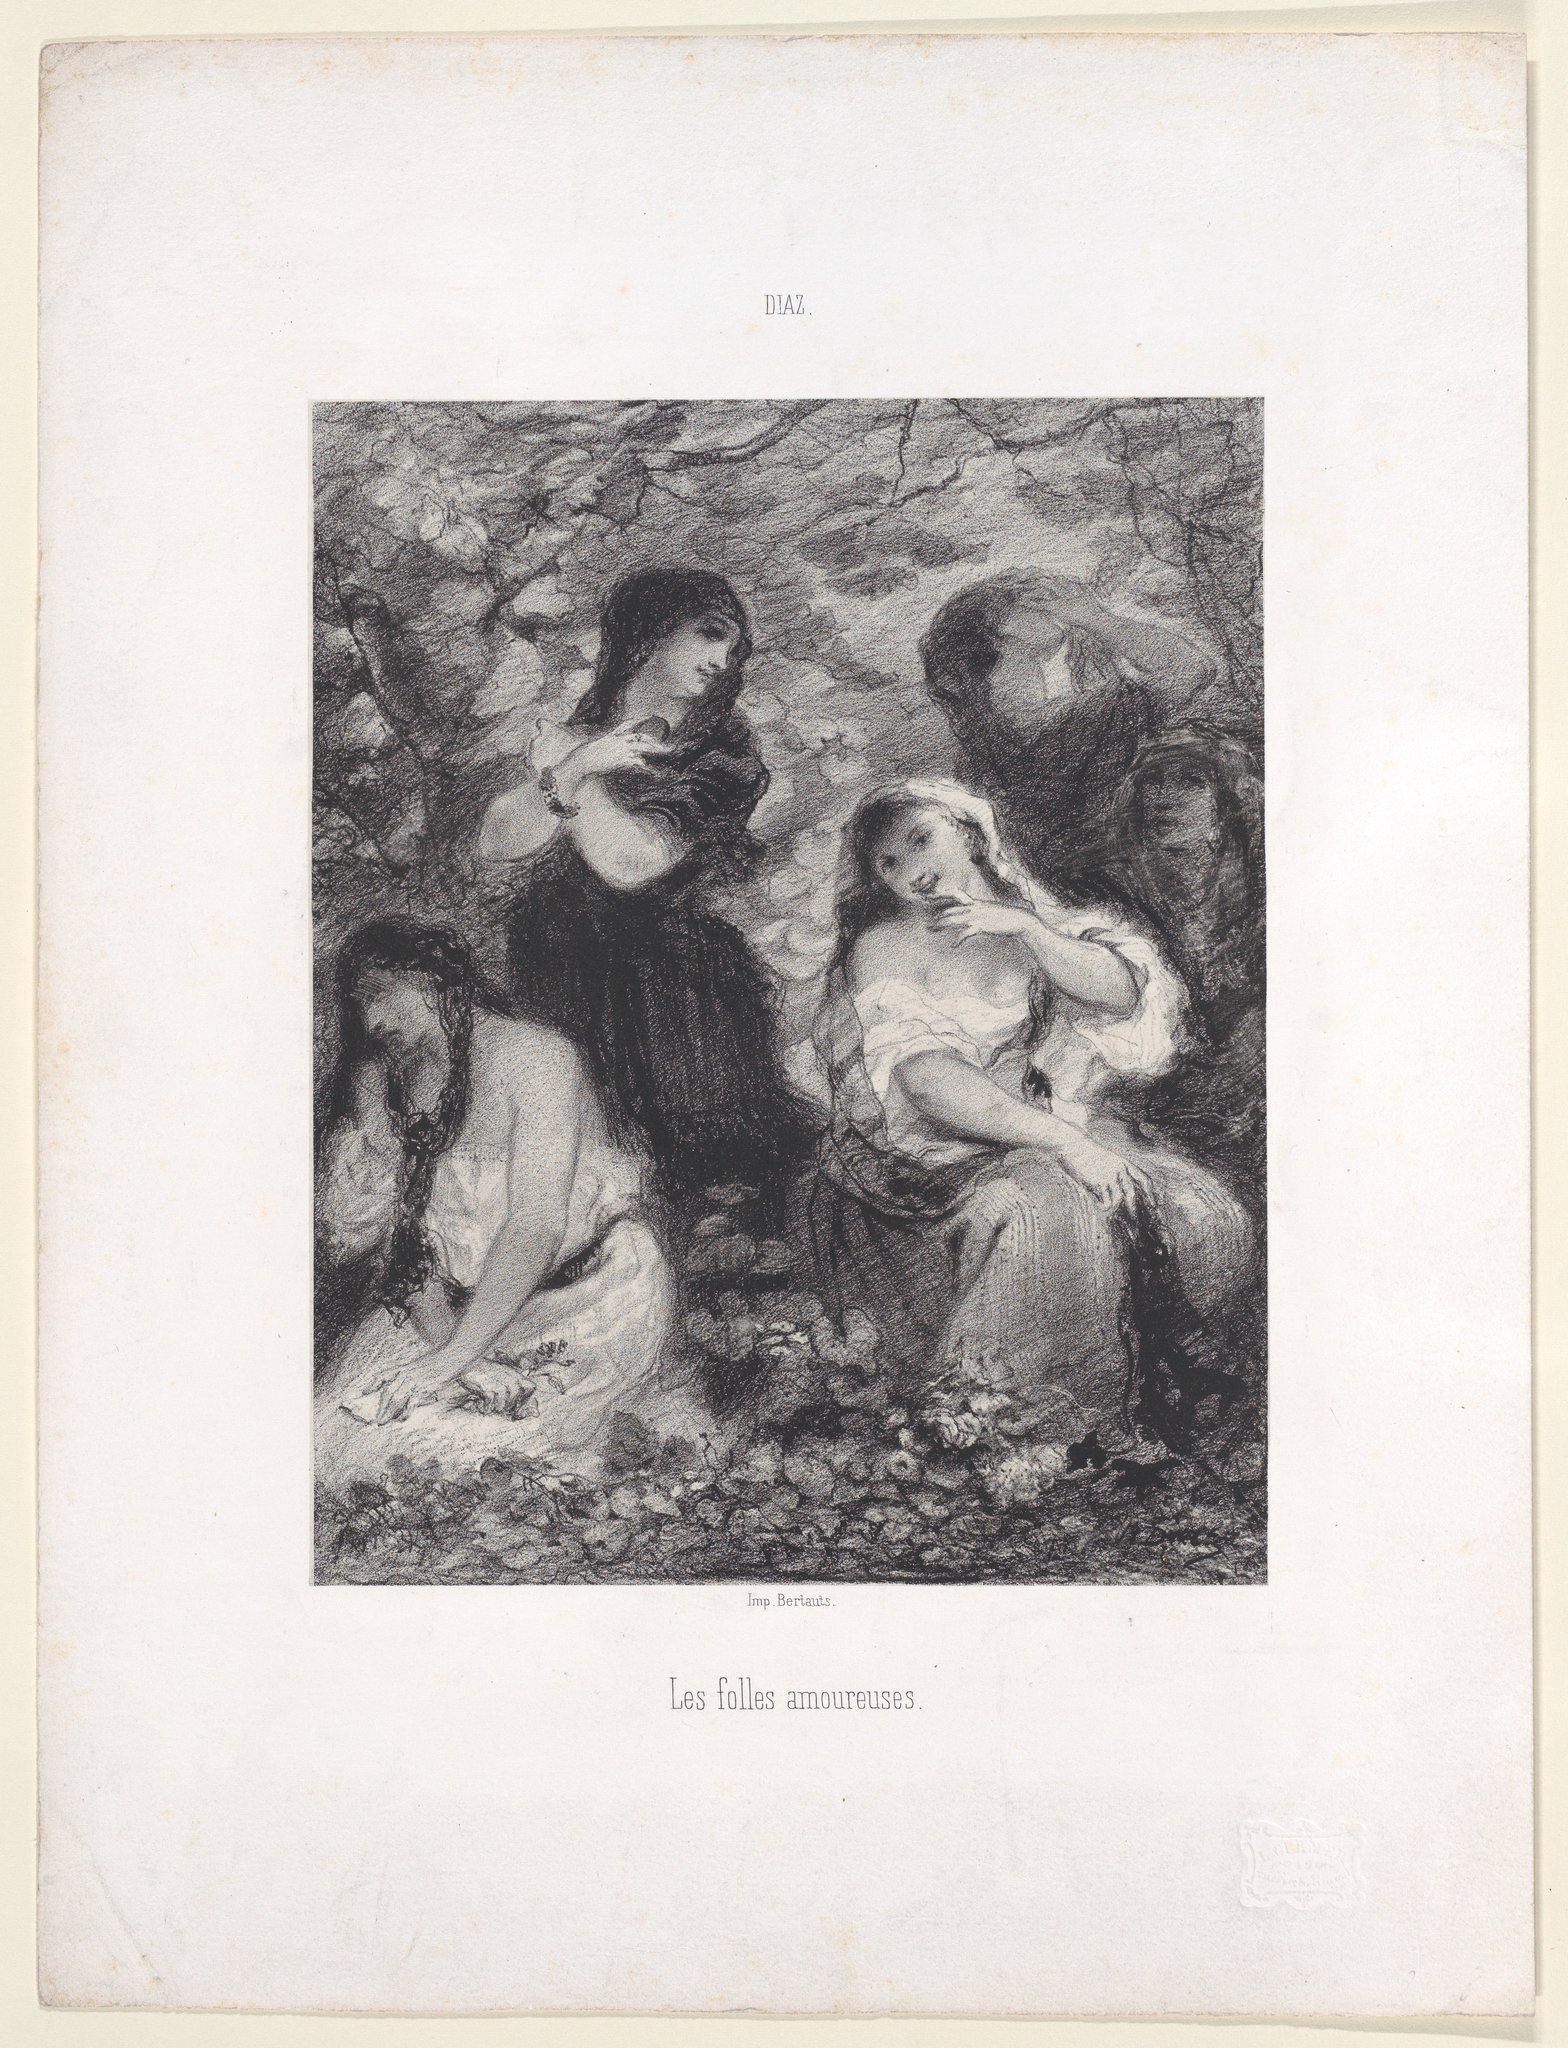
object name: print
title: Les Folles Amoureuses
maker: narcisse-virgile diaz de la peña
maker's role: artist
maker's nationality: french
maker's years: 1808-1876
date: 1830-1876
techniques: lithograph